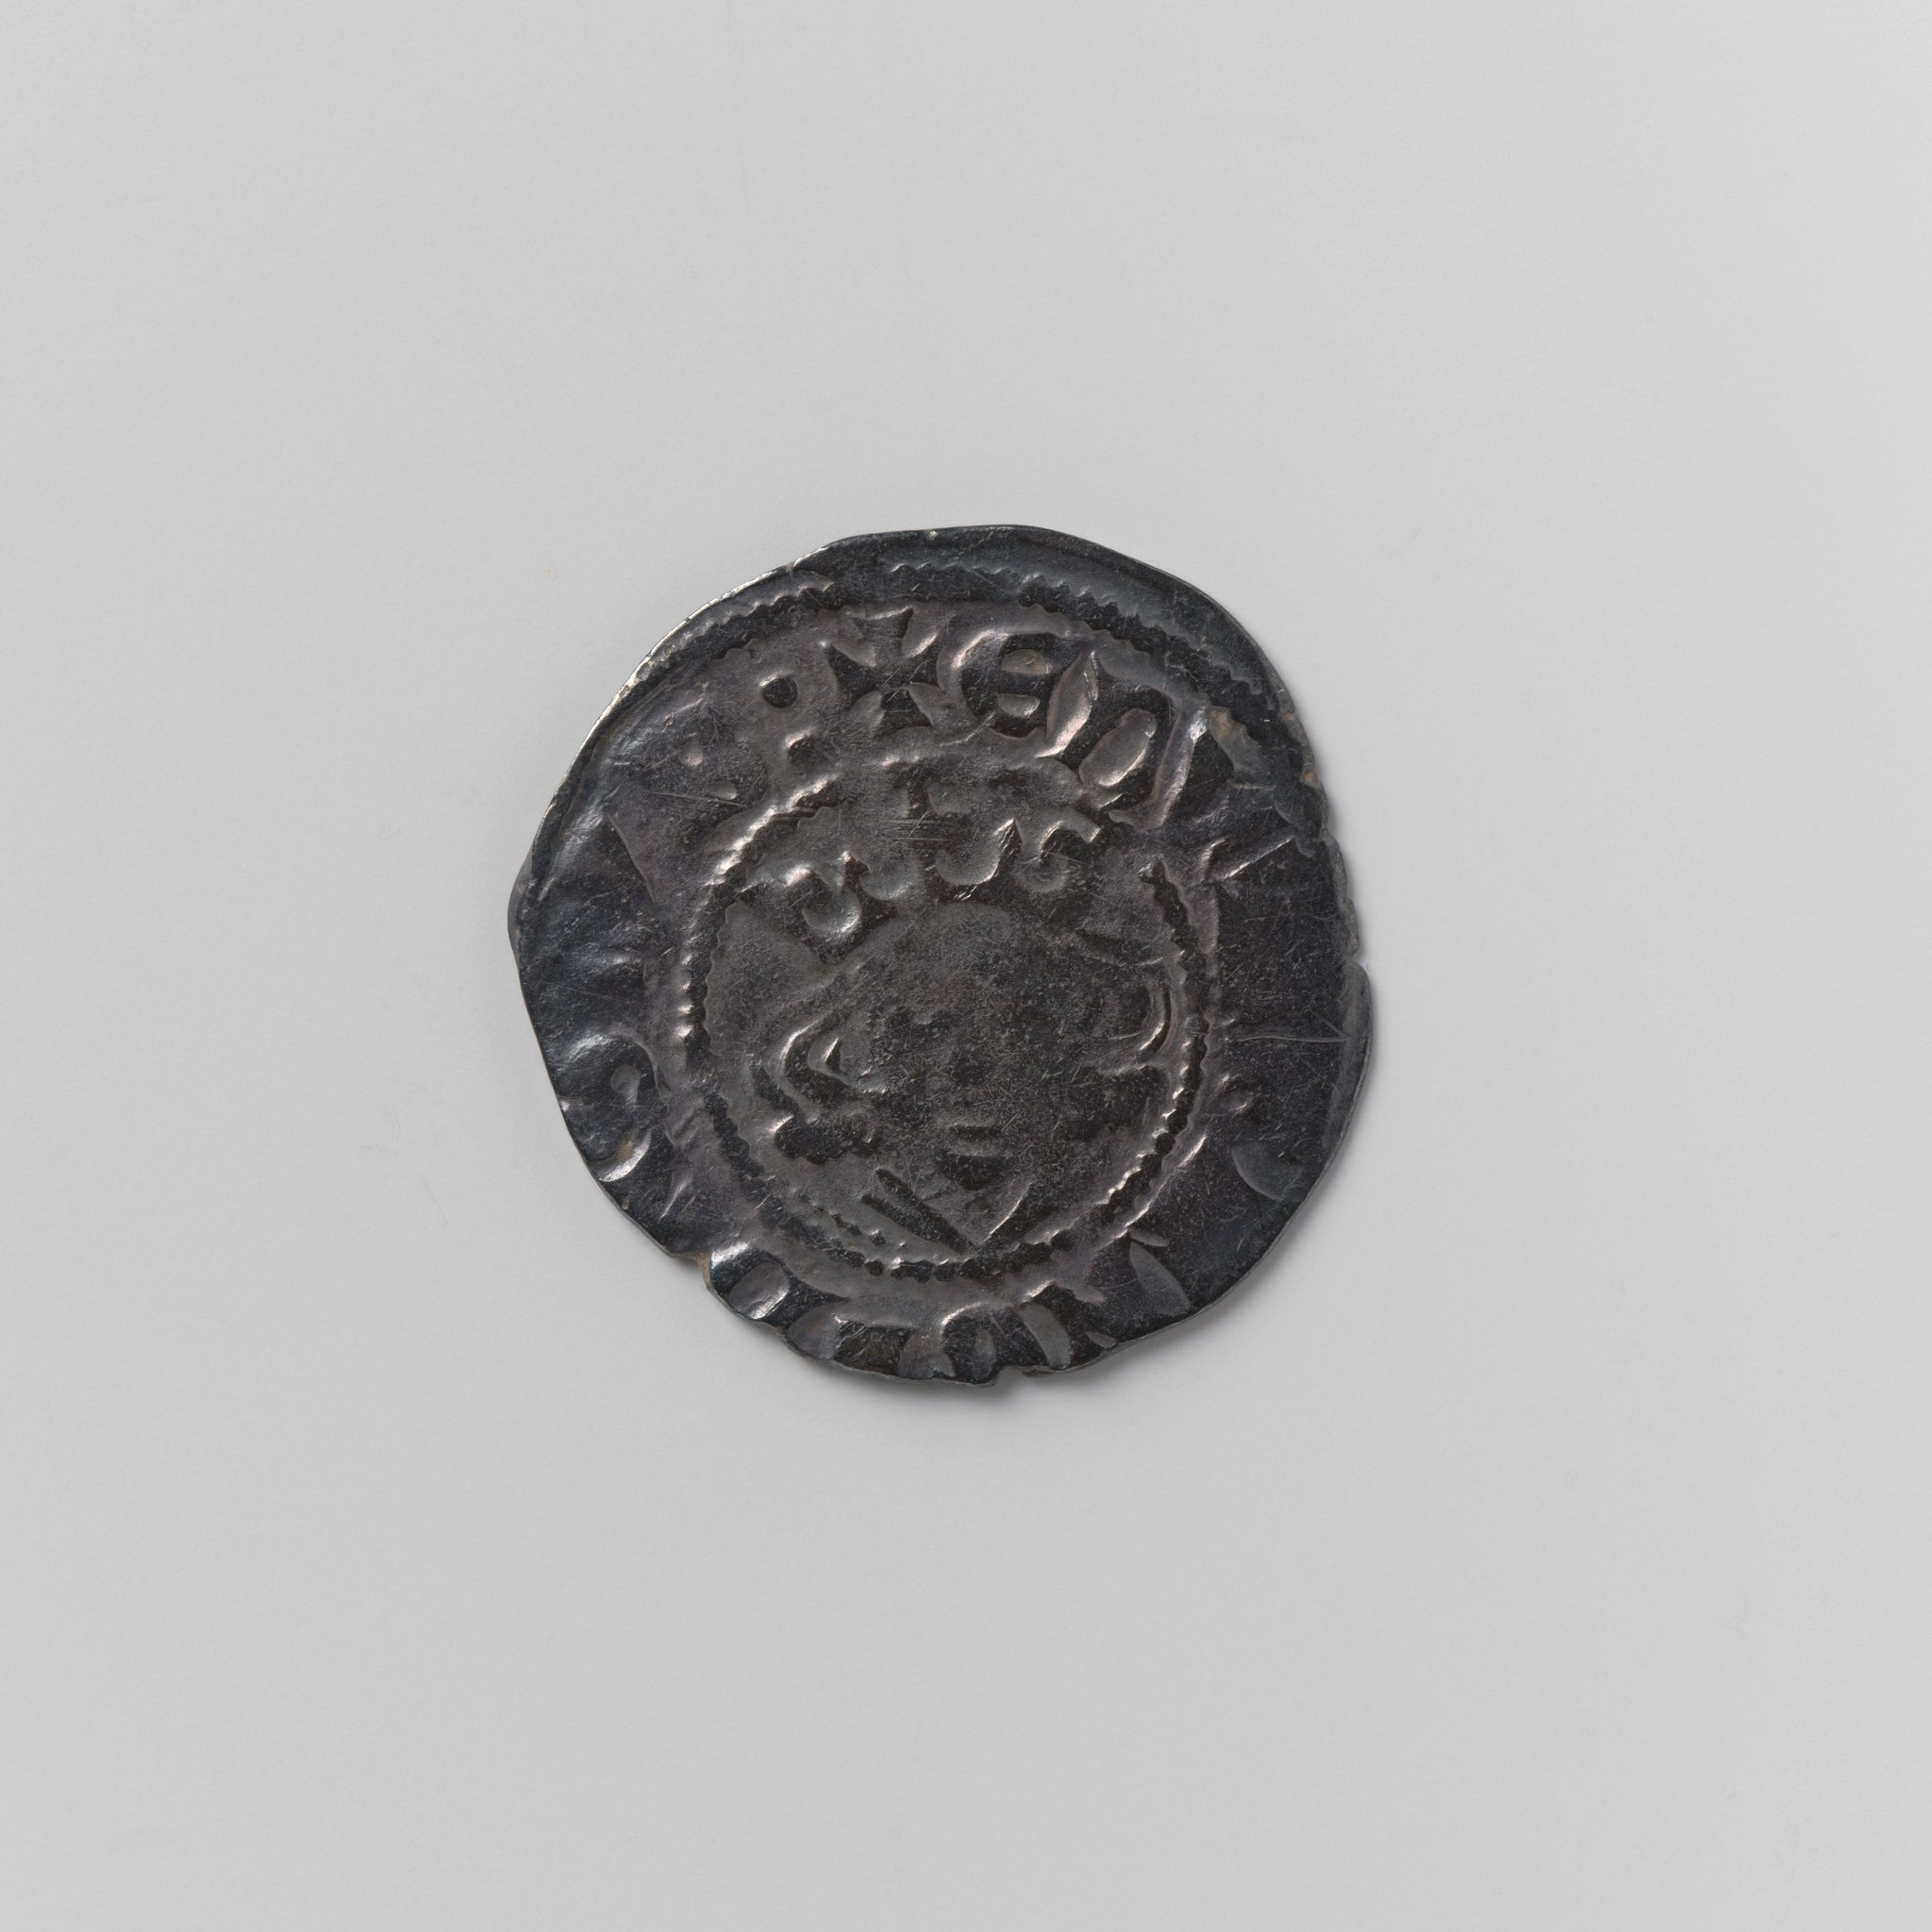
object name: coin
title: Penny uit Engeland van Edward I/II/III, 1272-1377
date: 1279-1377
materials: silver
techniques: striking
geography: london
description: Zilveren munt. Voorzijde: aanziend gekroond hoofd. Keerzijde: lang enkellijnig gevoet kruis.